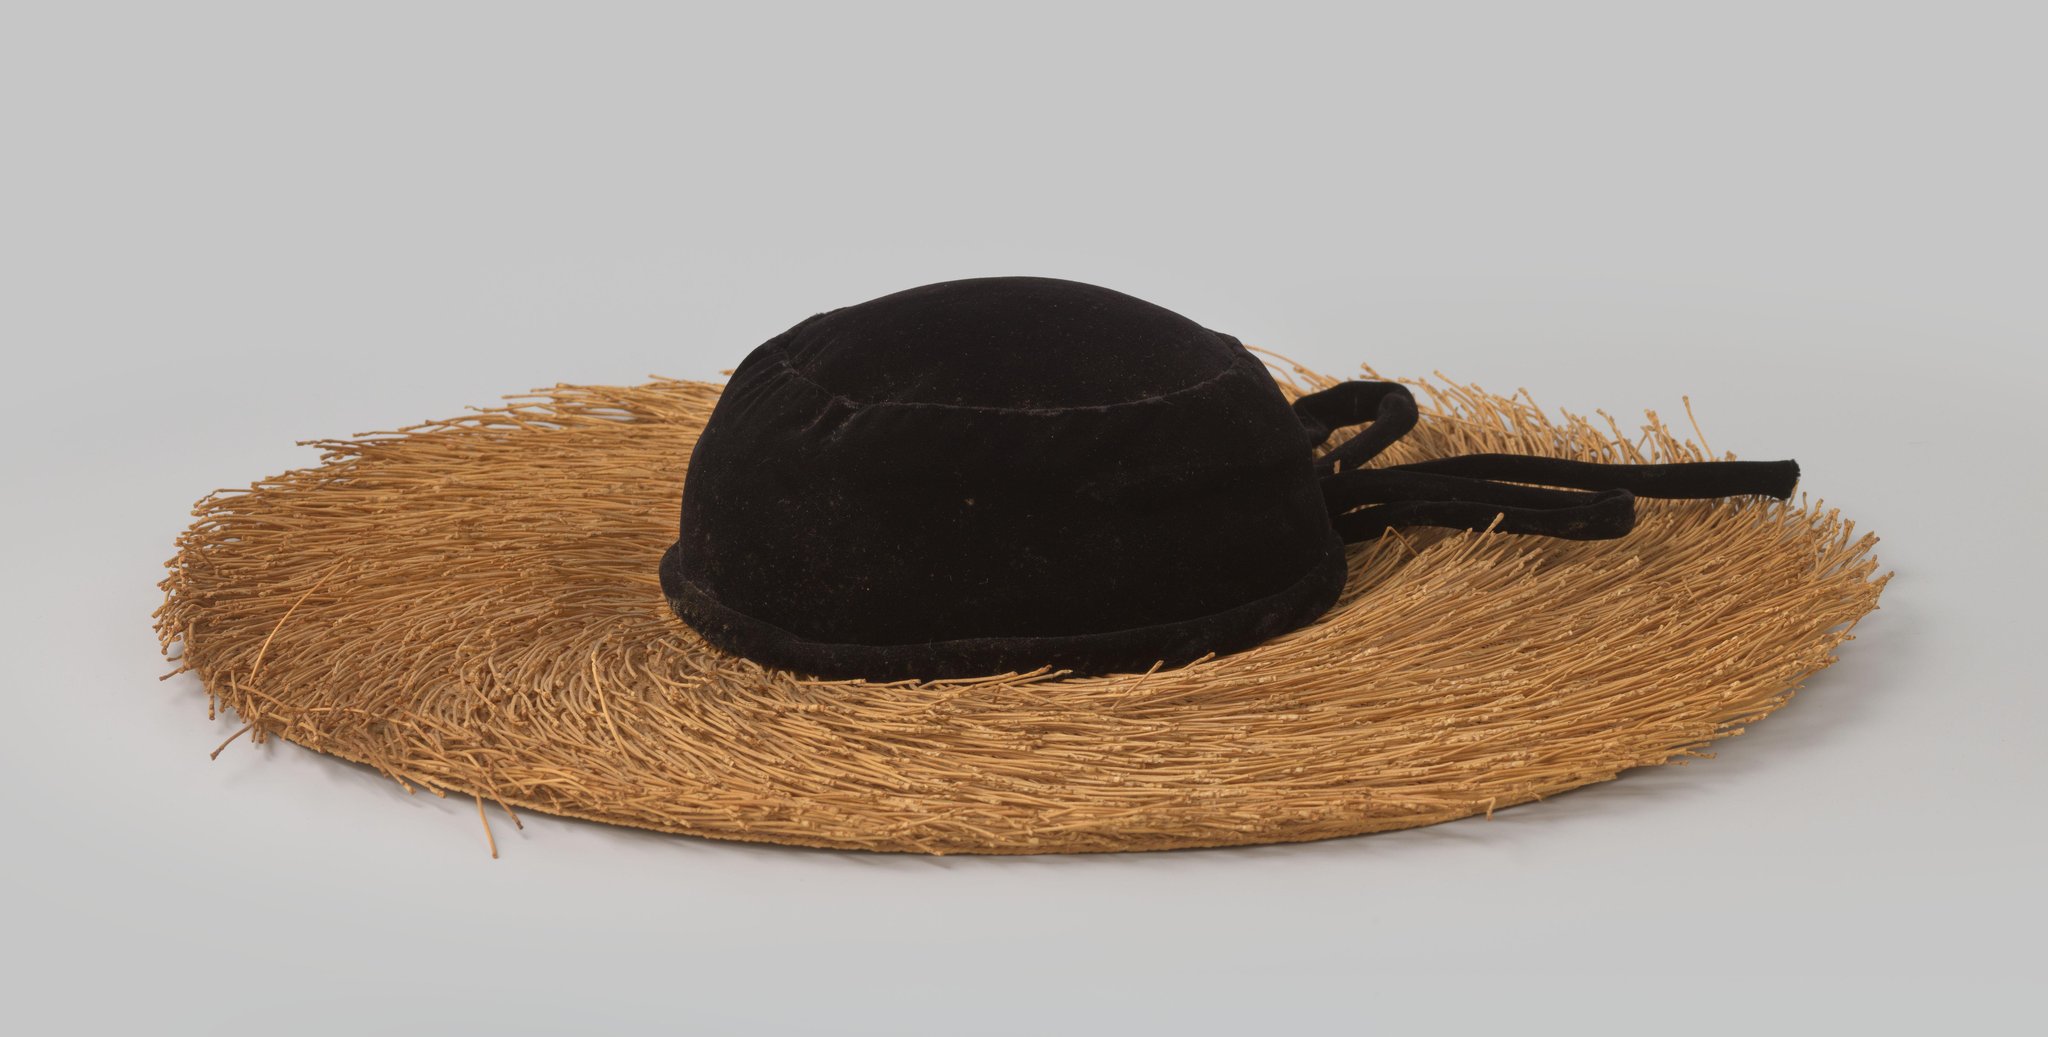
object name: hat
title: Hoed met lage bol van zwart fluweel en brede rand van gevlochten stro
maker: Anonymous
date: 1939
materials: chine, velvet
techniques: braiding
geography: netherlands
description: Hoed met lage bol van zwart fluweel en brede rand van gevlochten stro waaruit uiteinden van stro steken, gevoerd met zwarte crêpe de Chine. De bol is geheel bekleed met zwart fluweel en afgezet met een smalle rand fluweel, dat middenachter eindigt in een grote strik. De rand is gevlochten van grof stro.